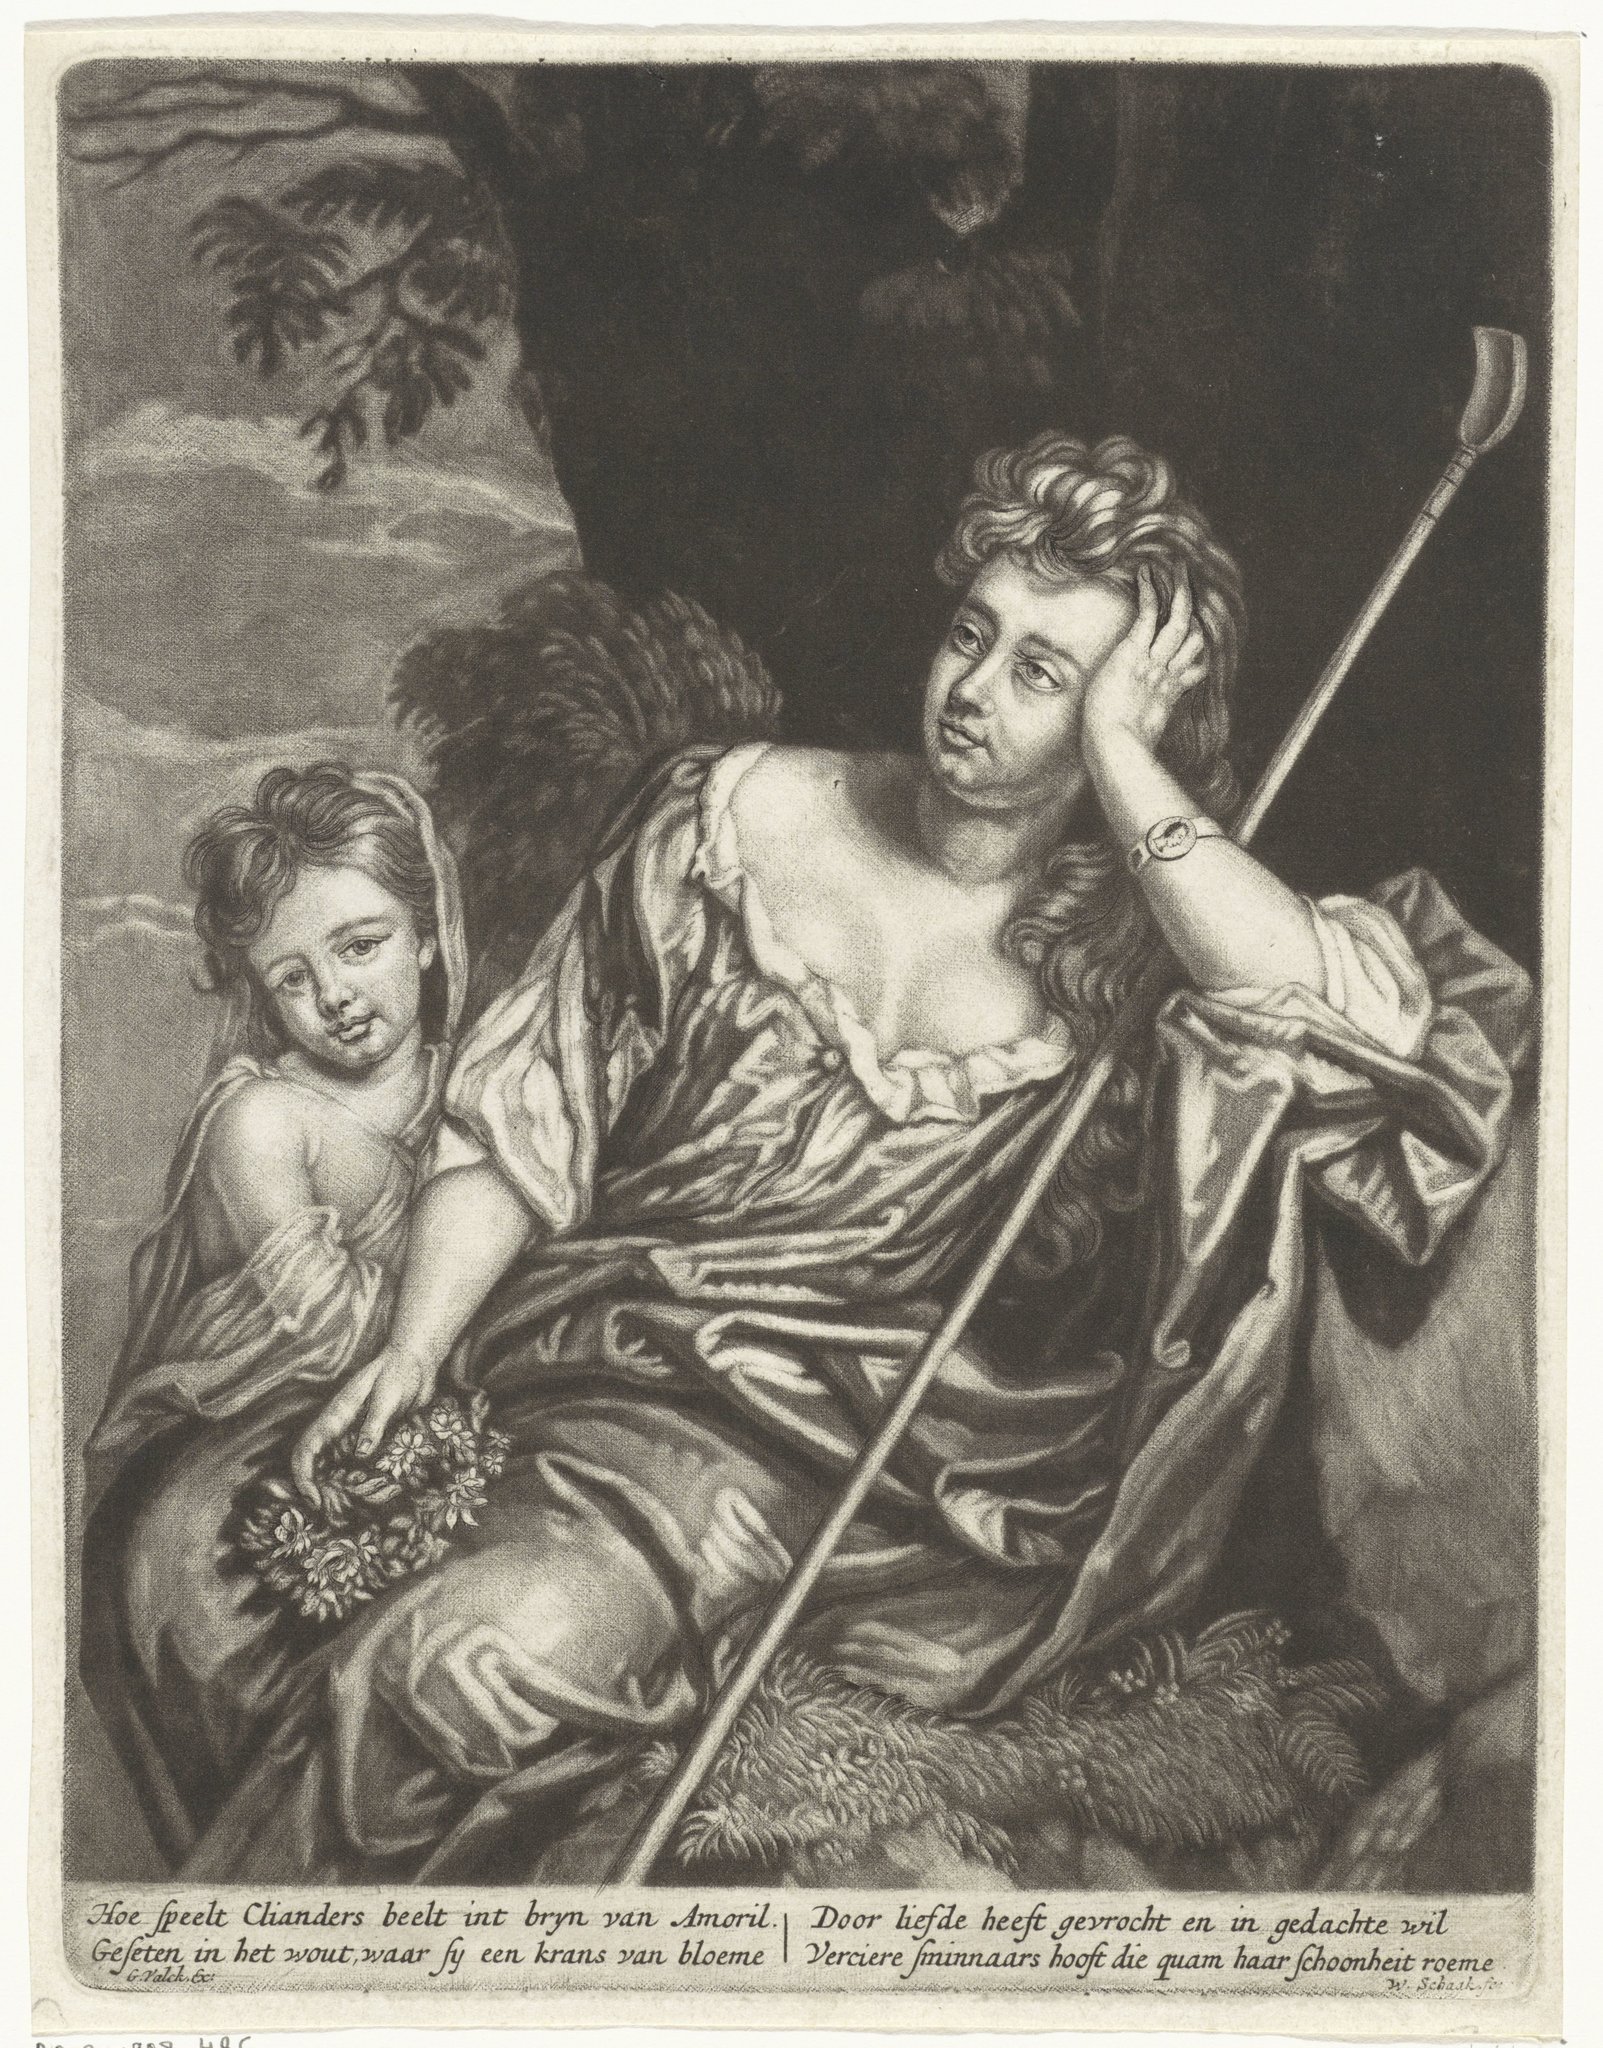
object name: print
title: Amoril denkt aan Cliander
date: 1680-1726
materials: paper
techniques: engraving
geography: amsterdam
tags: trees, herding, herdsman, herdswoman, shepherd, shepherdess, cowherd, etc., lover crowned with a wreath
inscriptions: collector's mark: Lugt 2228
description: De herderin Amoril zit onder een boom te denken aan Cliander. In de hand heeft ze een bloemenkrans en naast haar staat een kind. Om de pols draagt ze een bandje waaraan een medaillion met het portret van een man. In de marge een verklaring van de afbeelding.